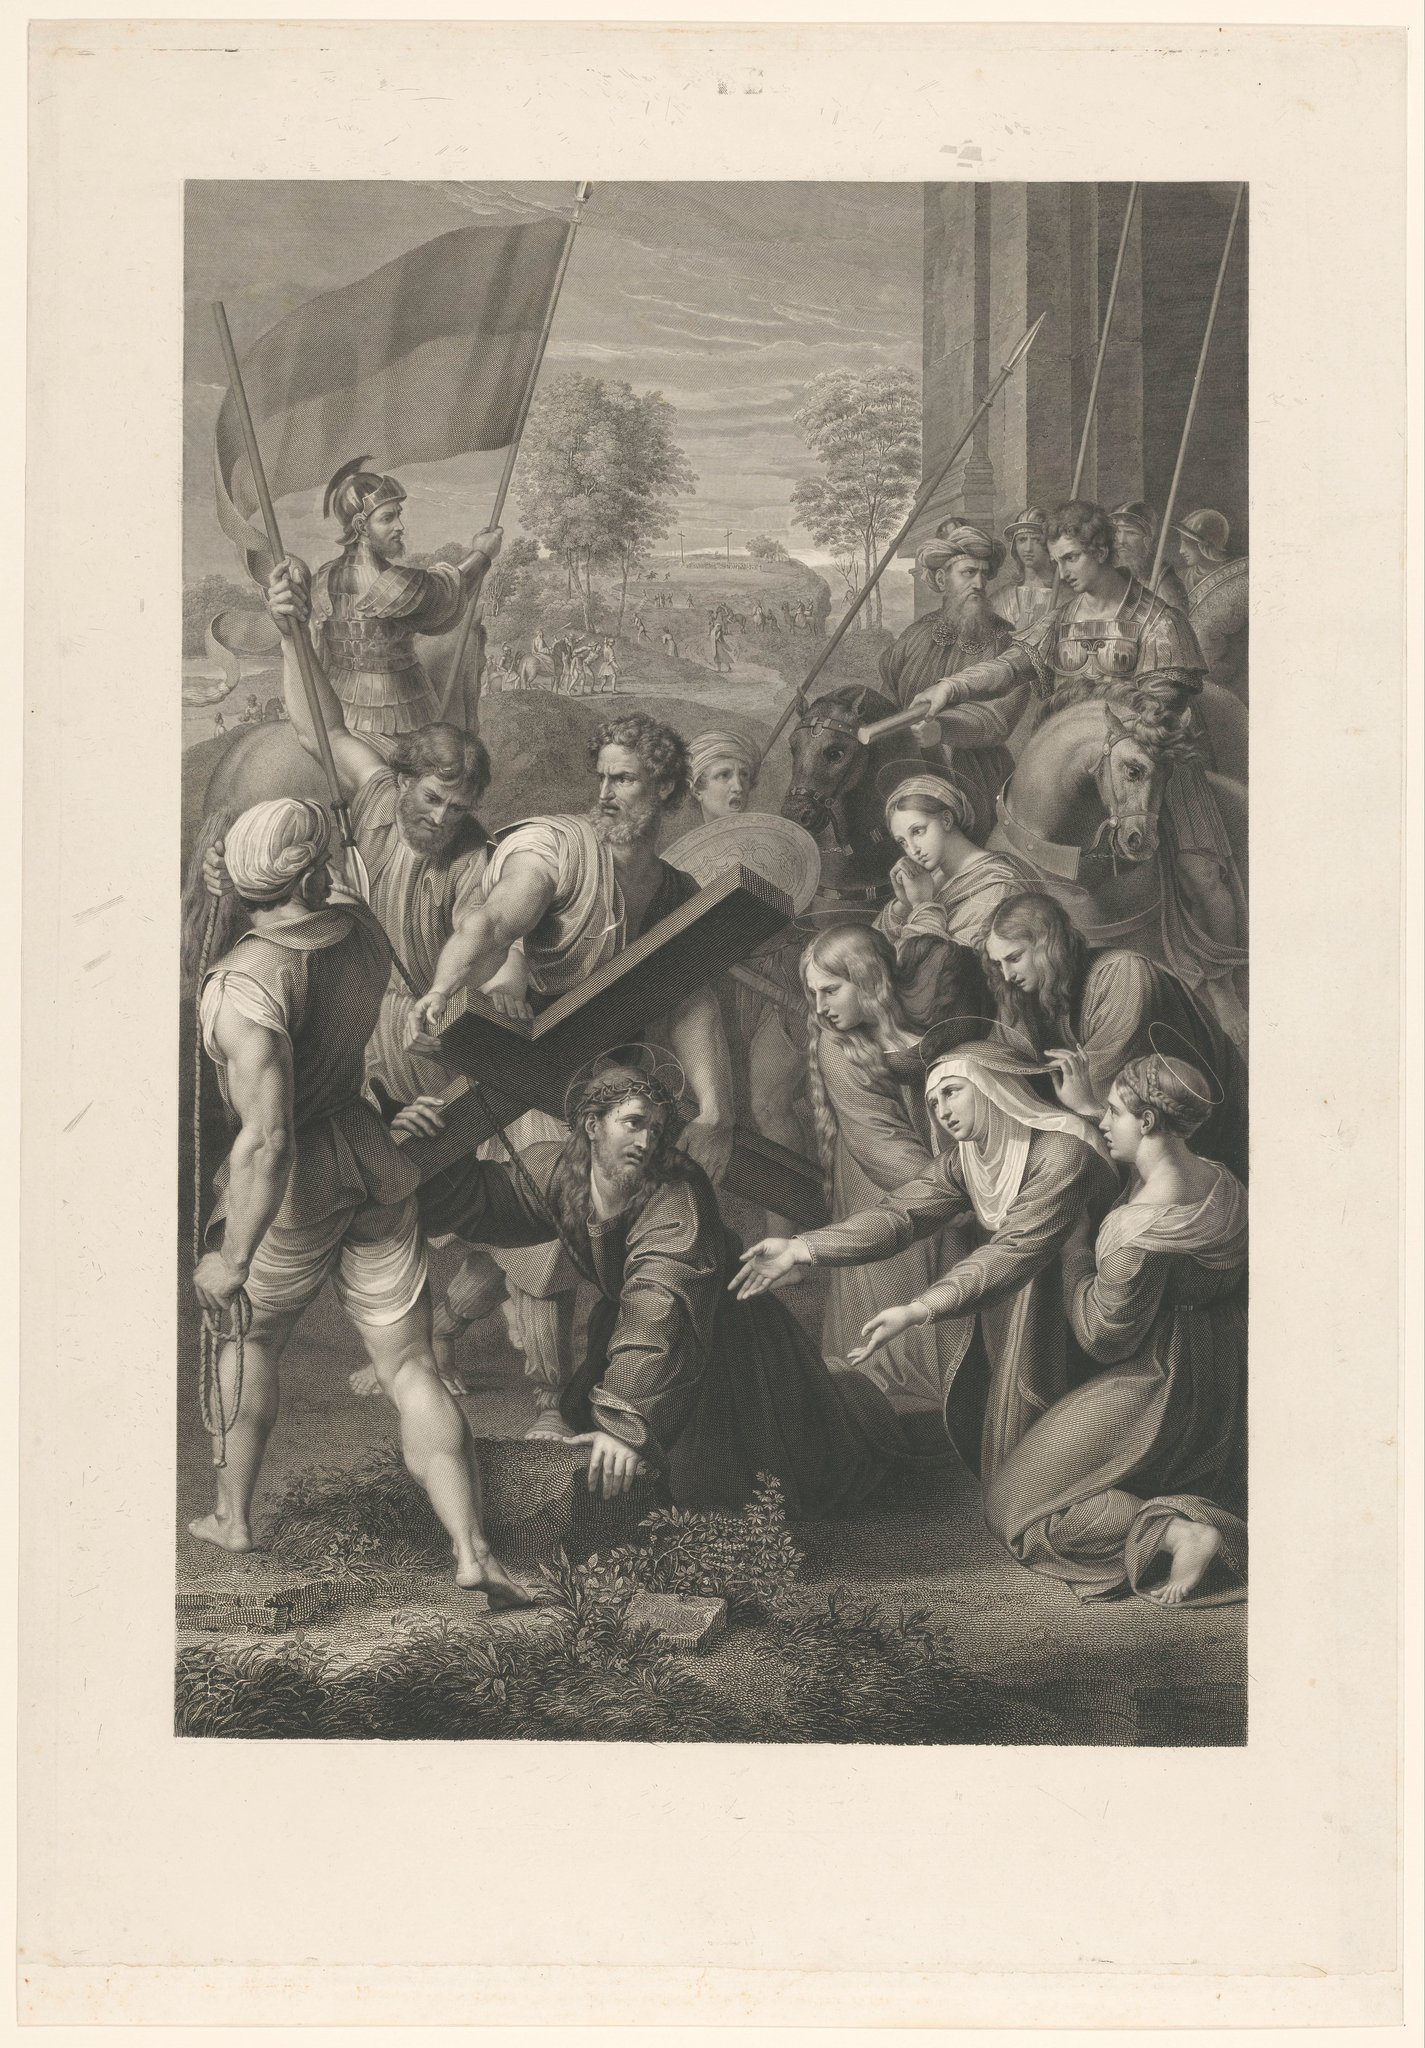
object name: print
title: Christus bezwijkt onder het gewicht van het kruis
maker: paolo toschi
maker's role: print maker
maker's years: 1788-1854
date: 1798-1854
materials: paper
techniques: engraving, etching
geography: italy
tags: carrying of the cross: christ bearing the cross, alone or with the help of others (e.g. simon the cyrenian)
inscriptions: collector's mark: Lugt 12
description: Christus bezwijkt onder het gewicht van het kruis dat hij op zijn schouders draagt op de weg naar Golgota. Soldaten trekken aan Christus met touwen en richten hun speren op hem. Christus kijkt om naar de Maria's en Johannes de Evangelist.